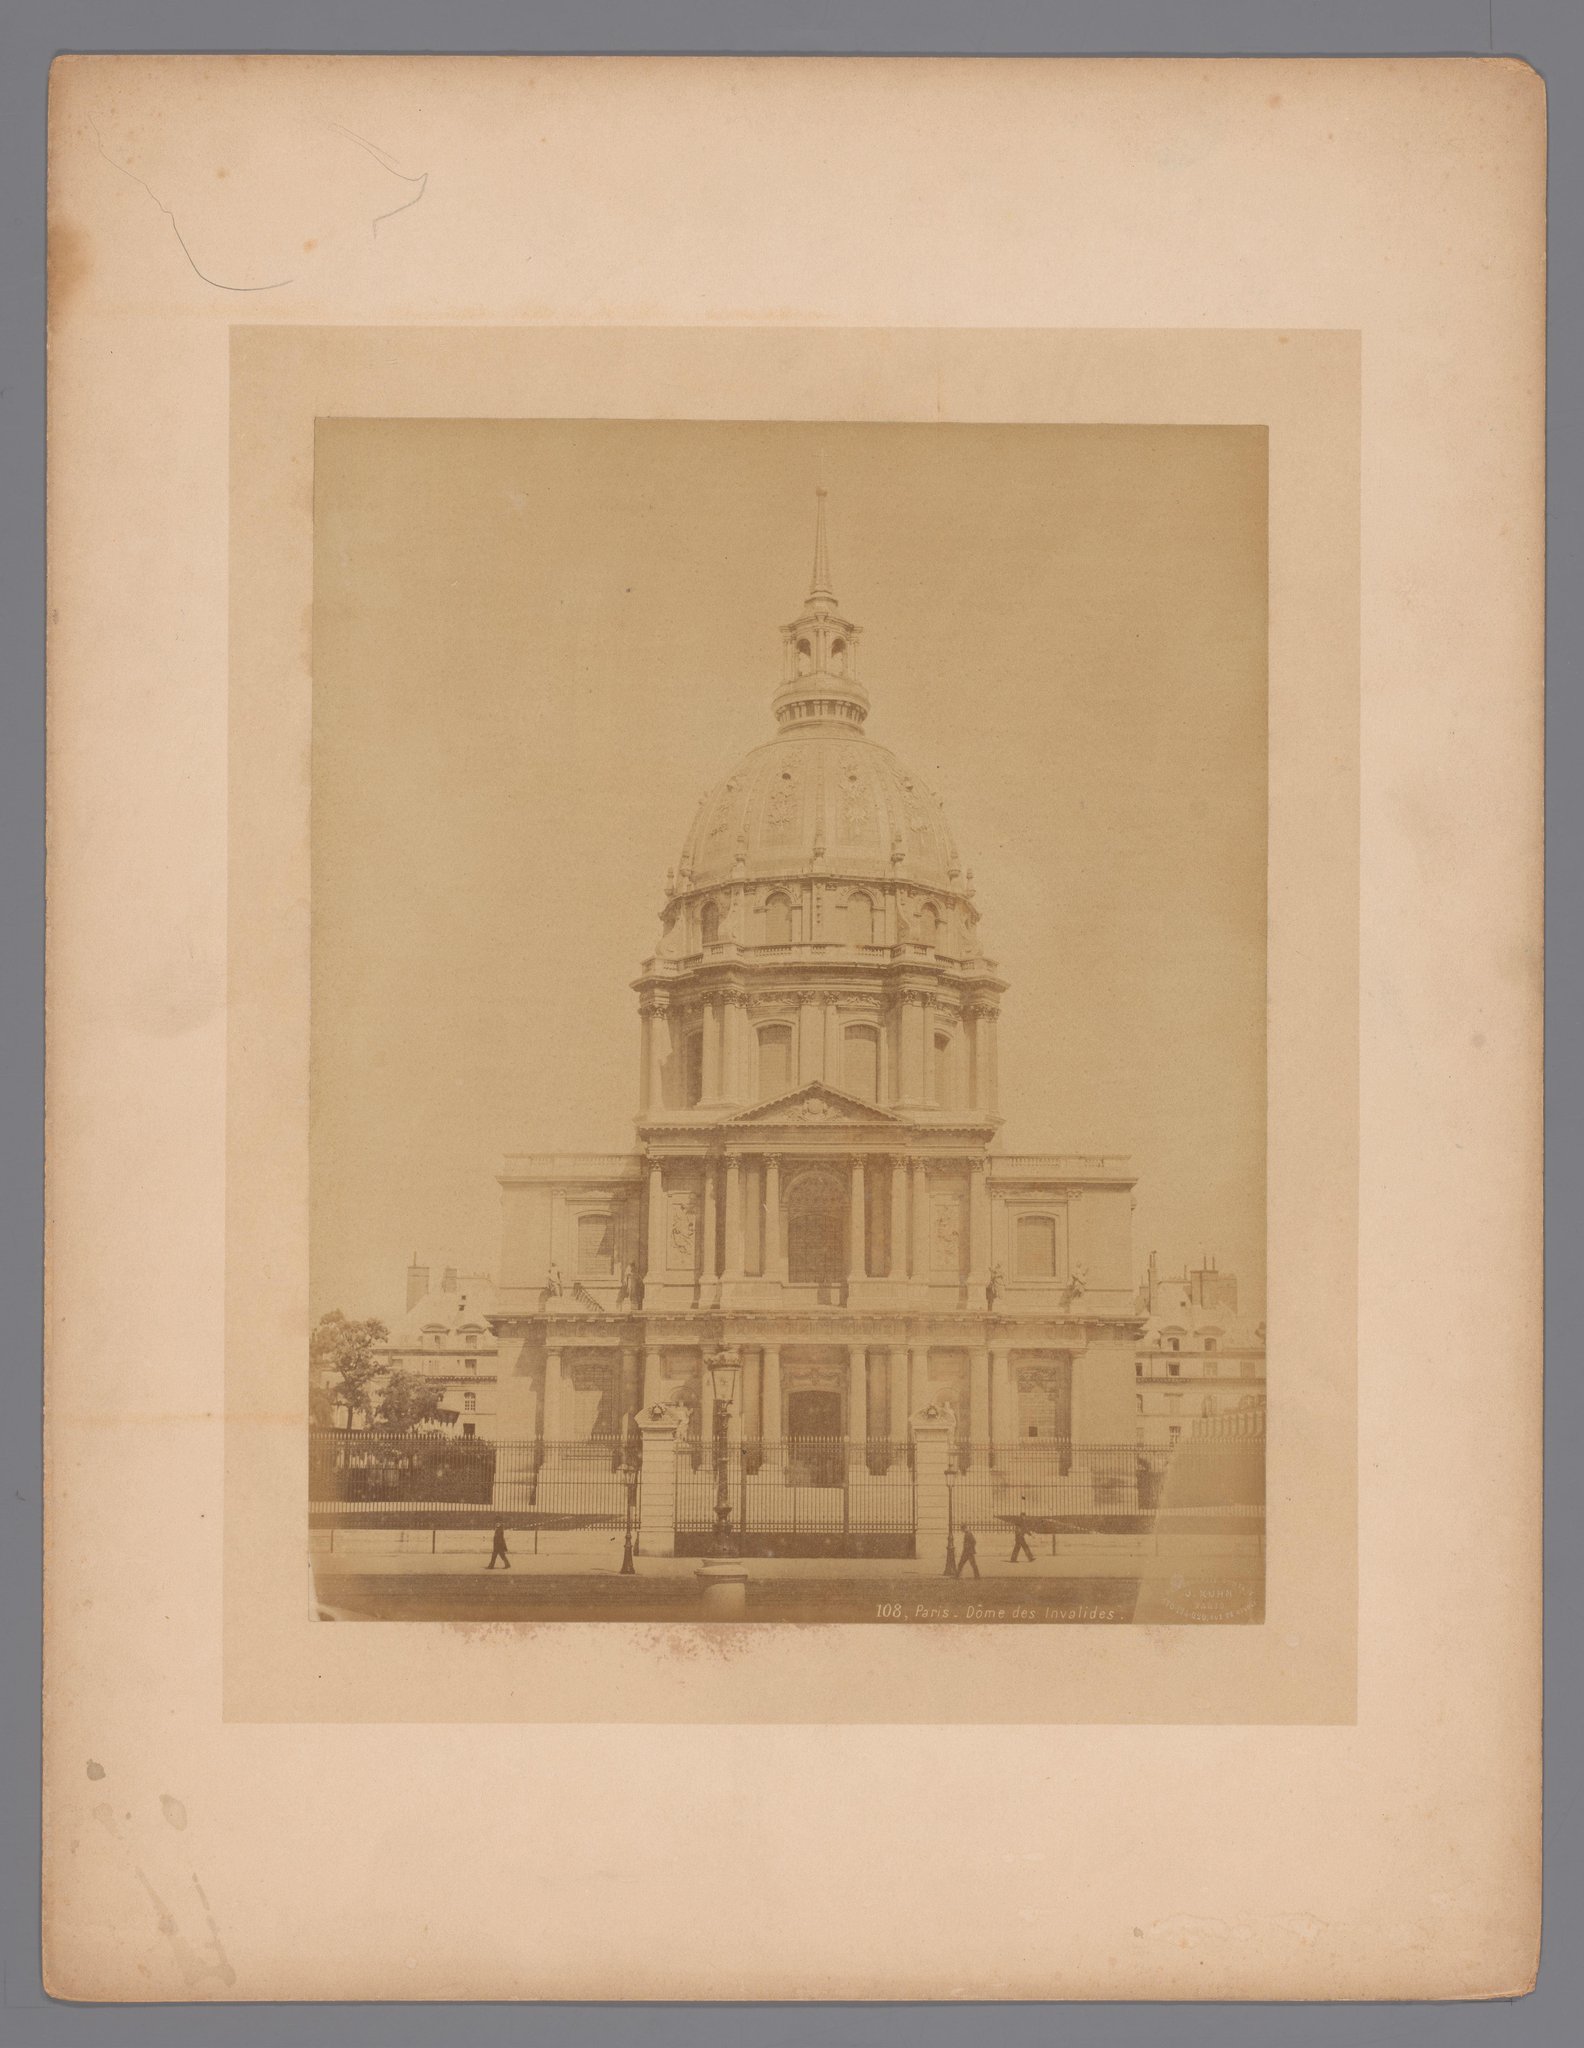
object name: photograph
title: Hôtel National des Invalides ('Dôme des Invalides'), Parijs, Frankrijk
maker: j. kühn (uitgever)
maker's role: publisher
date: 1885-1910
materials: cardboard, photographic support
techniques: albumen print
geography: paris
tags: dôme des invalides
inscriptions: inscription: ‘108, Paris - Dôme des Invalides’, number: ‘16.’, check stamp: ‘Photographic Company//J. Kühn//Paris//220 170174 Rue de Rivoli’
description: Frontaal anzicht op het Hôtel National des Invalides, gelegen in het 7e arrondissement van Parijs. Het werd in 1671 opgericht door Lodewijk XIV.